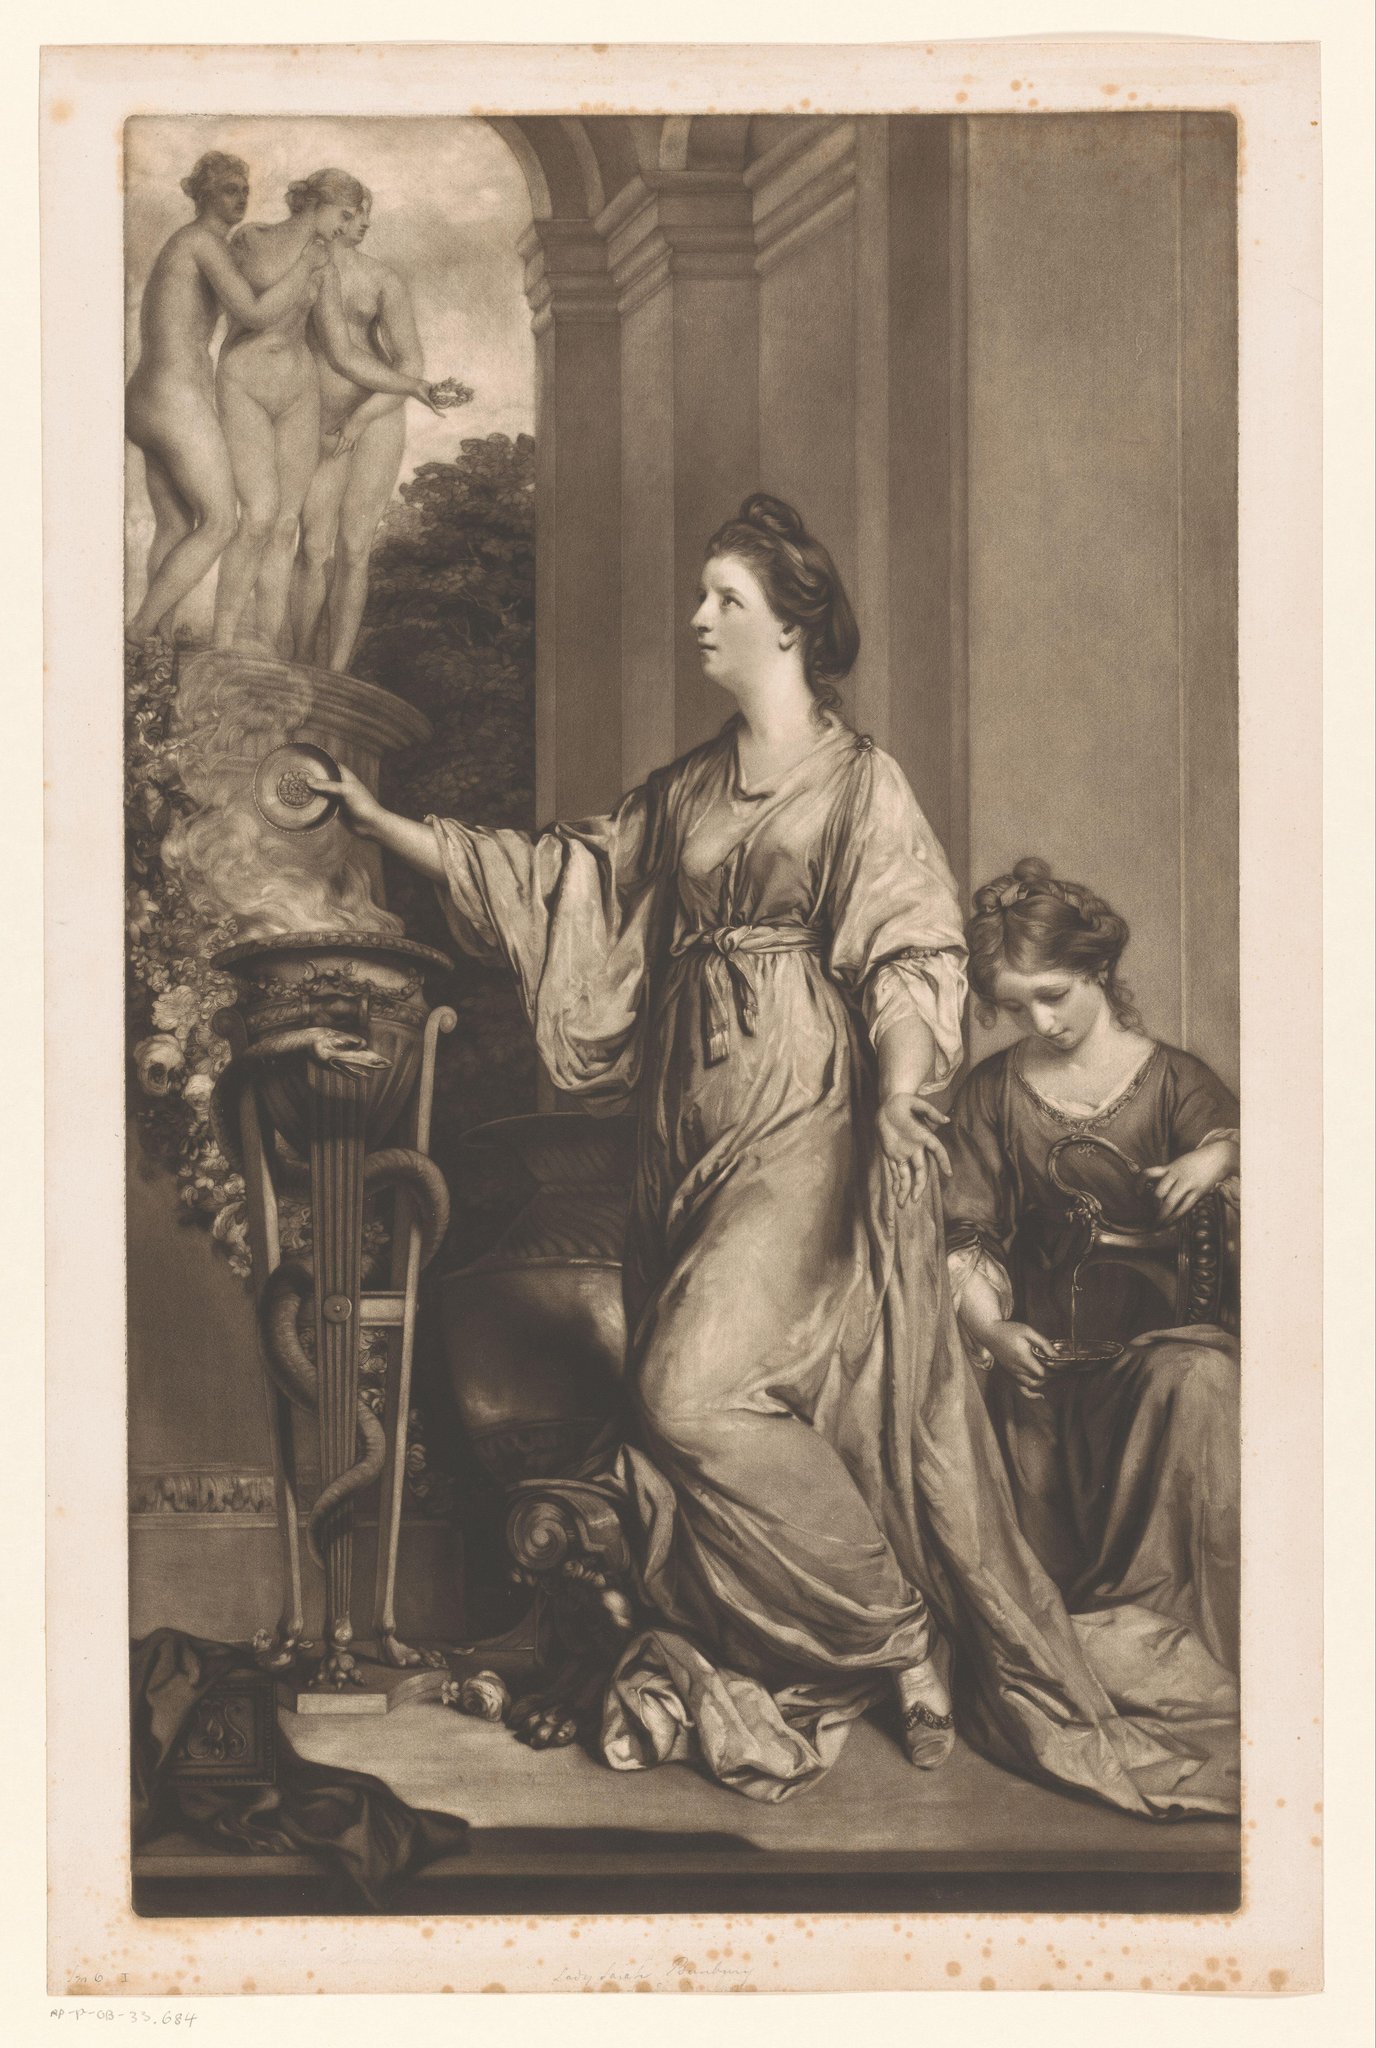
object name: print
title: Lady Sarah Bunbury Sacrificing to the Graces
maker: edward fisher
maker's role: print maker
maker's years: 1722-1785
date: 1765-1800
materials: paper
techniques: mezzotint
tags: historical persons, graces (charites), generally three in number; 'gratie' (ripa), page ~ court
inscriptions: collector's mark: Lugt 240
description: Een page schenkt water in een kom terwijl Sarah gewijd water op het vuur giet bij een altaar voor de drie Gratiën.